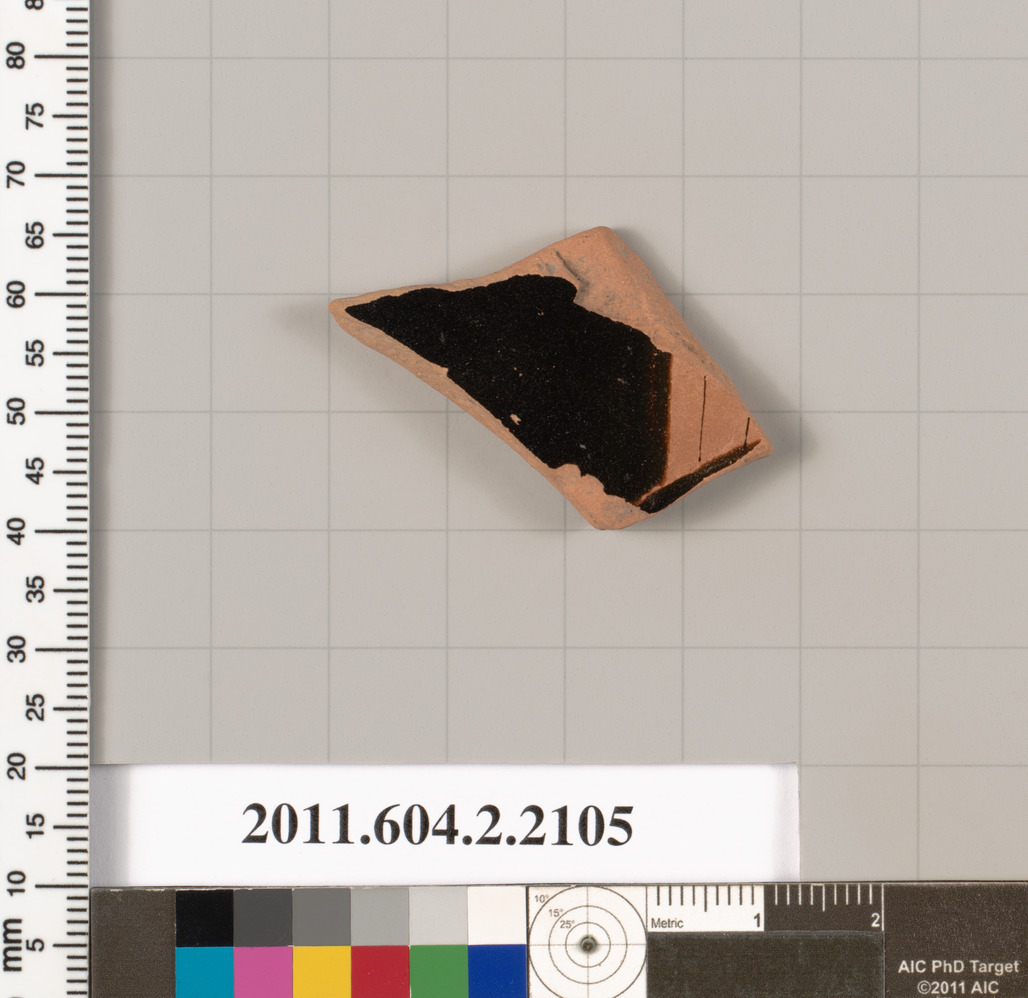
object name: pot fragment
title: Terracotta fragment of a pot; glazed on the inside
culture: greek, attic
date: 450-426 BCE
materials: terracotta